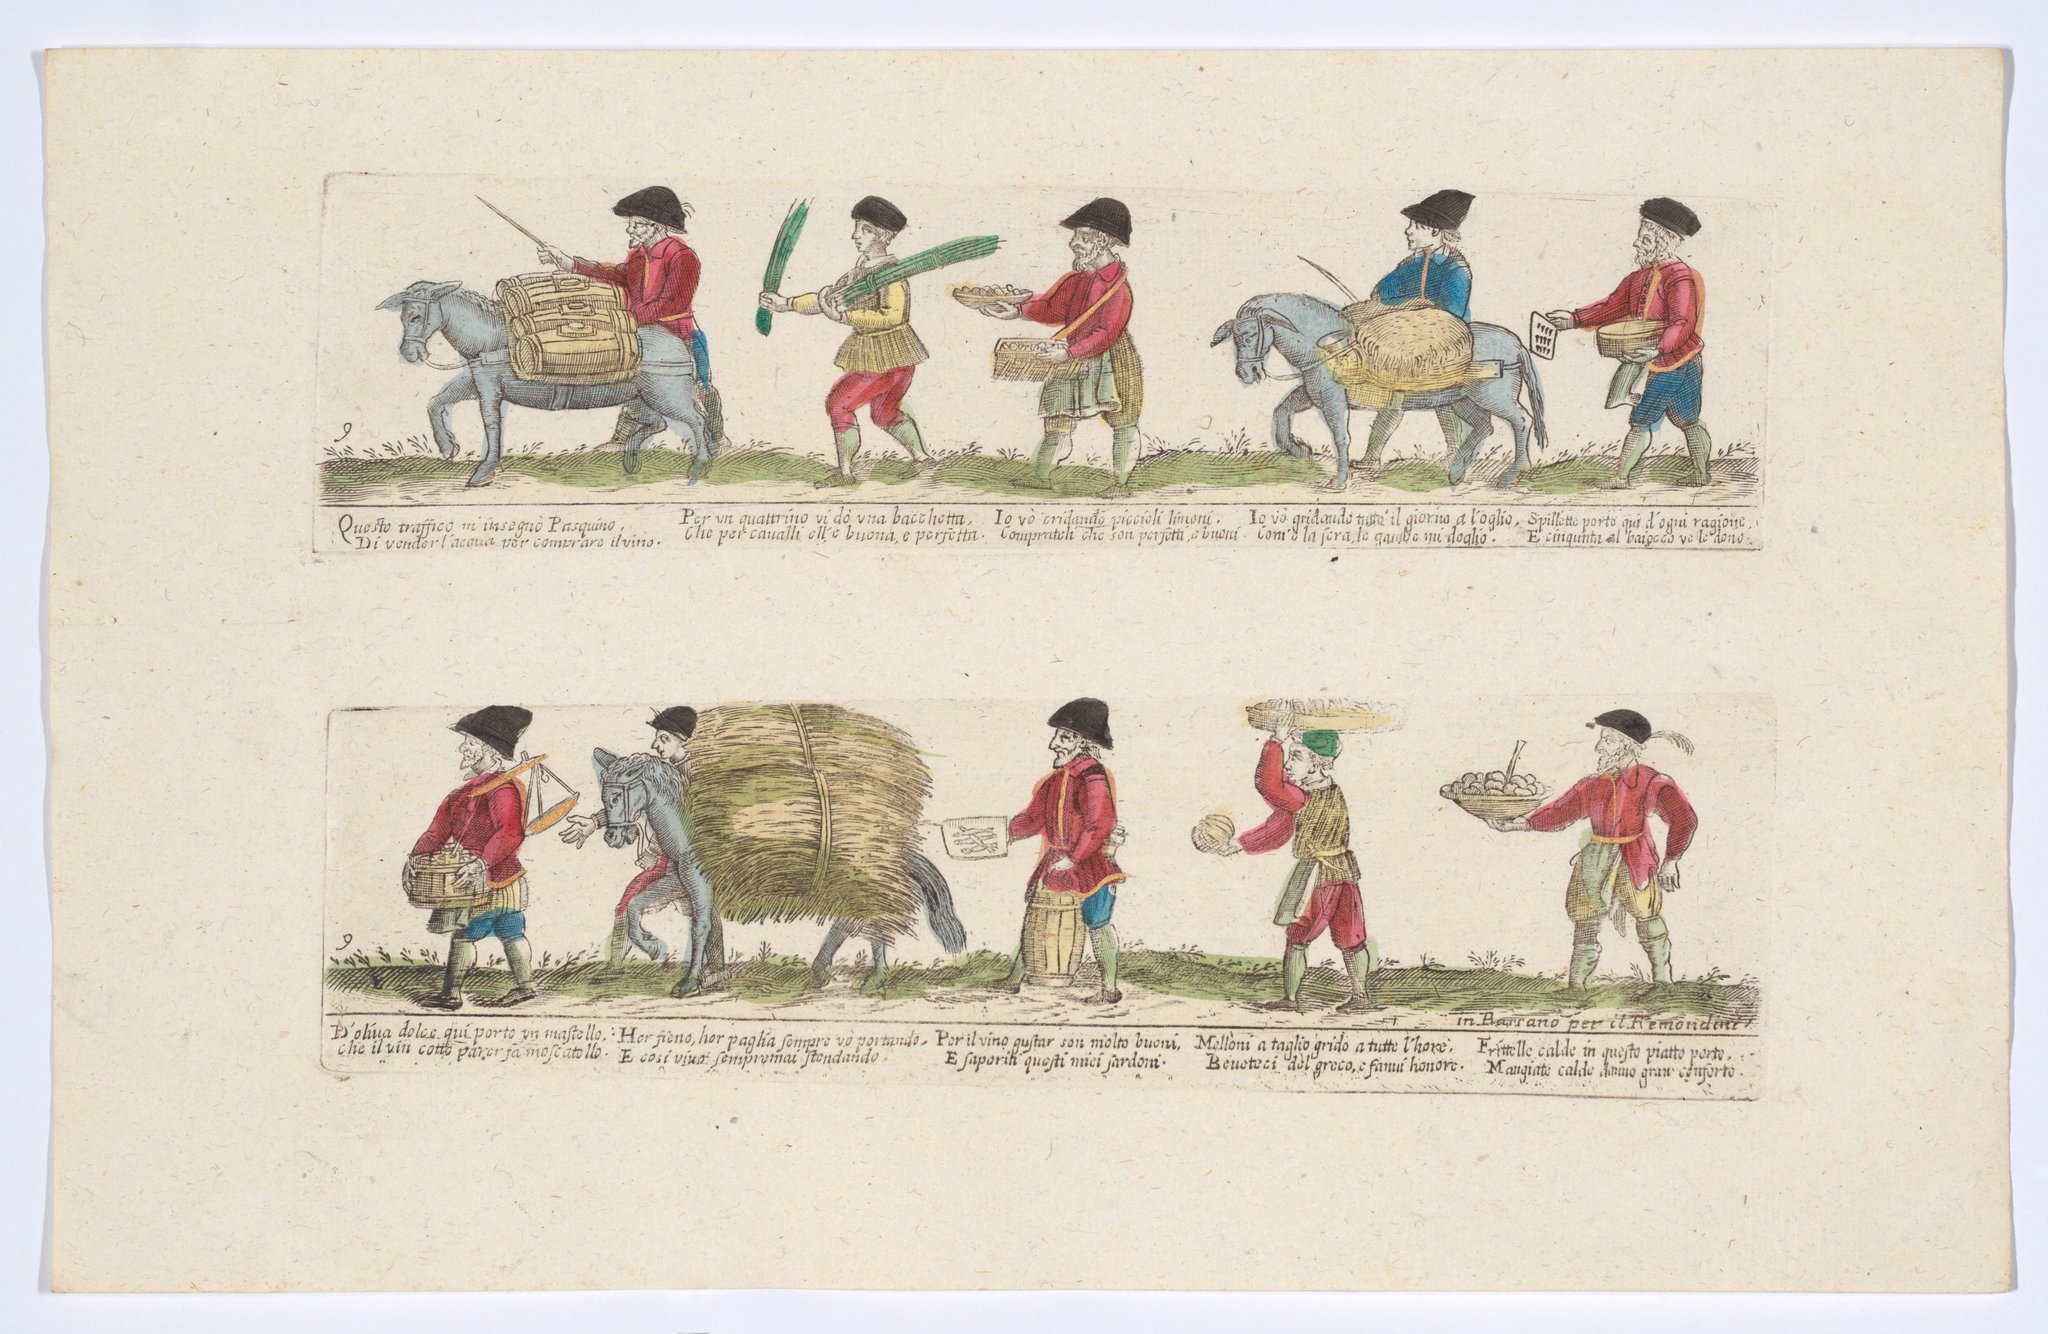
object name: print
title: Plate 9 depicting the trades of Rome, here including vendors of water, sardines, melons etc, from the 'Descrición de las artes que se llaman para los calles de la ciudad de Roma'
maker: remondini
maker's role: publisher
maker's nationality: italian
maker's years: 1650-1860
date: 1770-1800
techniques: engraving, hand coloring